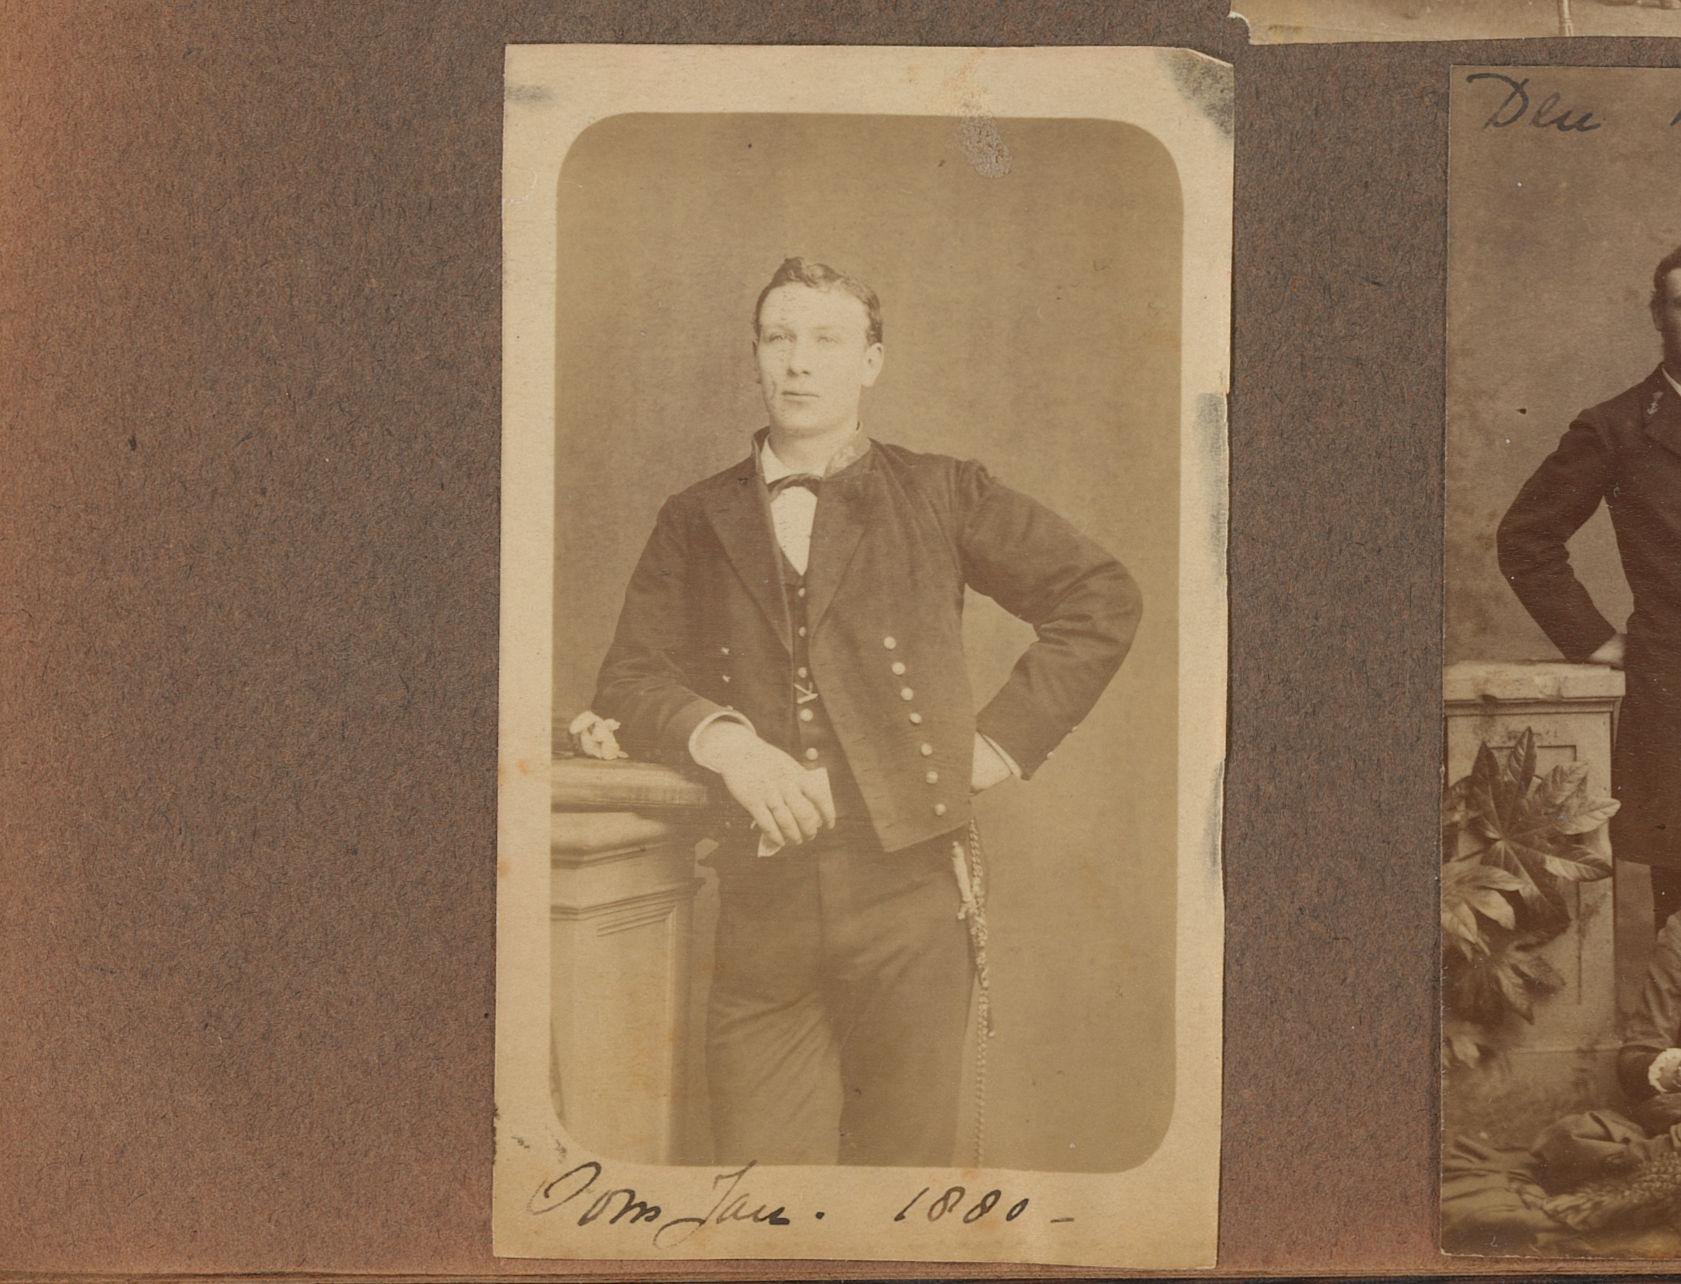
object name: photograph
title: Ome Jan 1880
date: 1880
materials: photographic support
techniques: photography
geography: amsterdam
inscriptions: inscription: ‘Ome Jan . 1880 -’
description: Foto op bruin albumblad 16 van familiealbum van Alphons Diepenbrock.